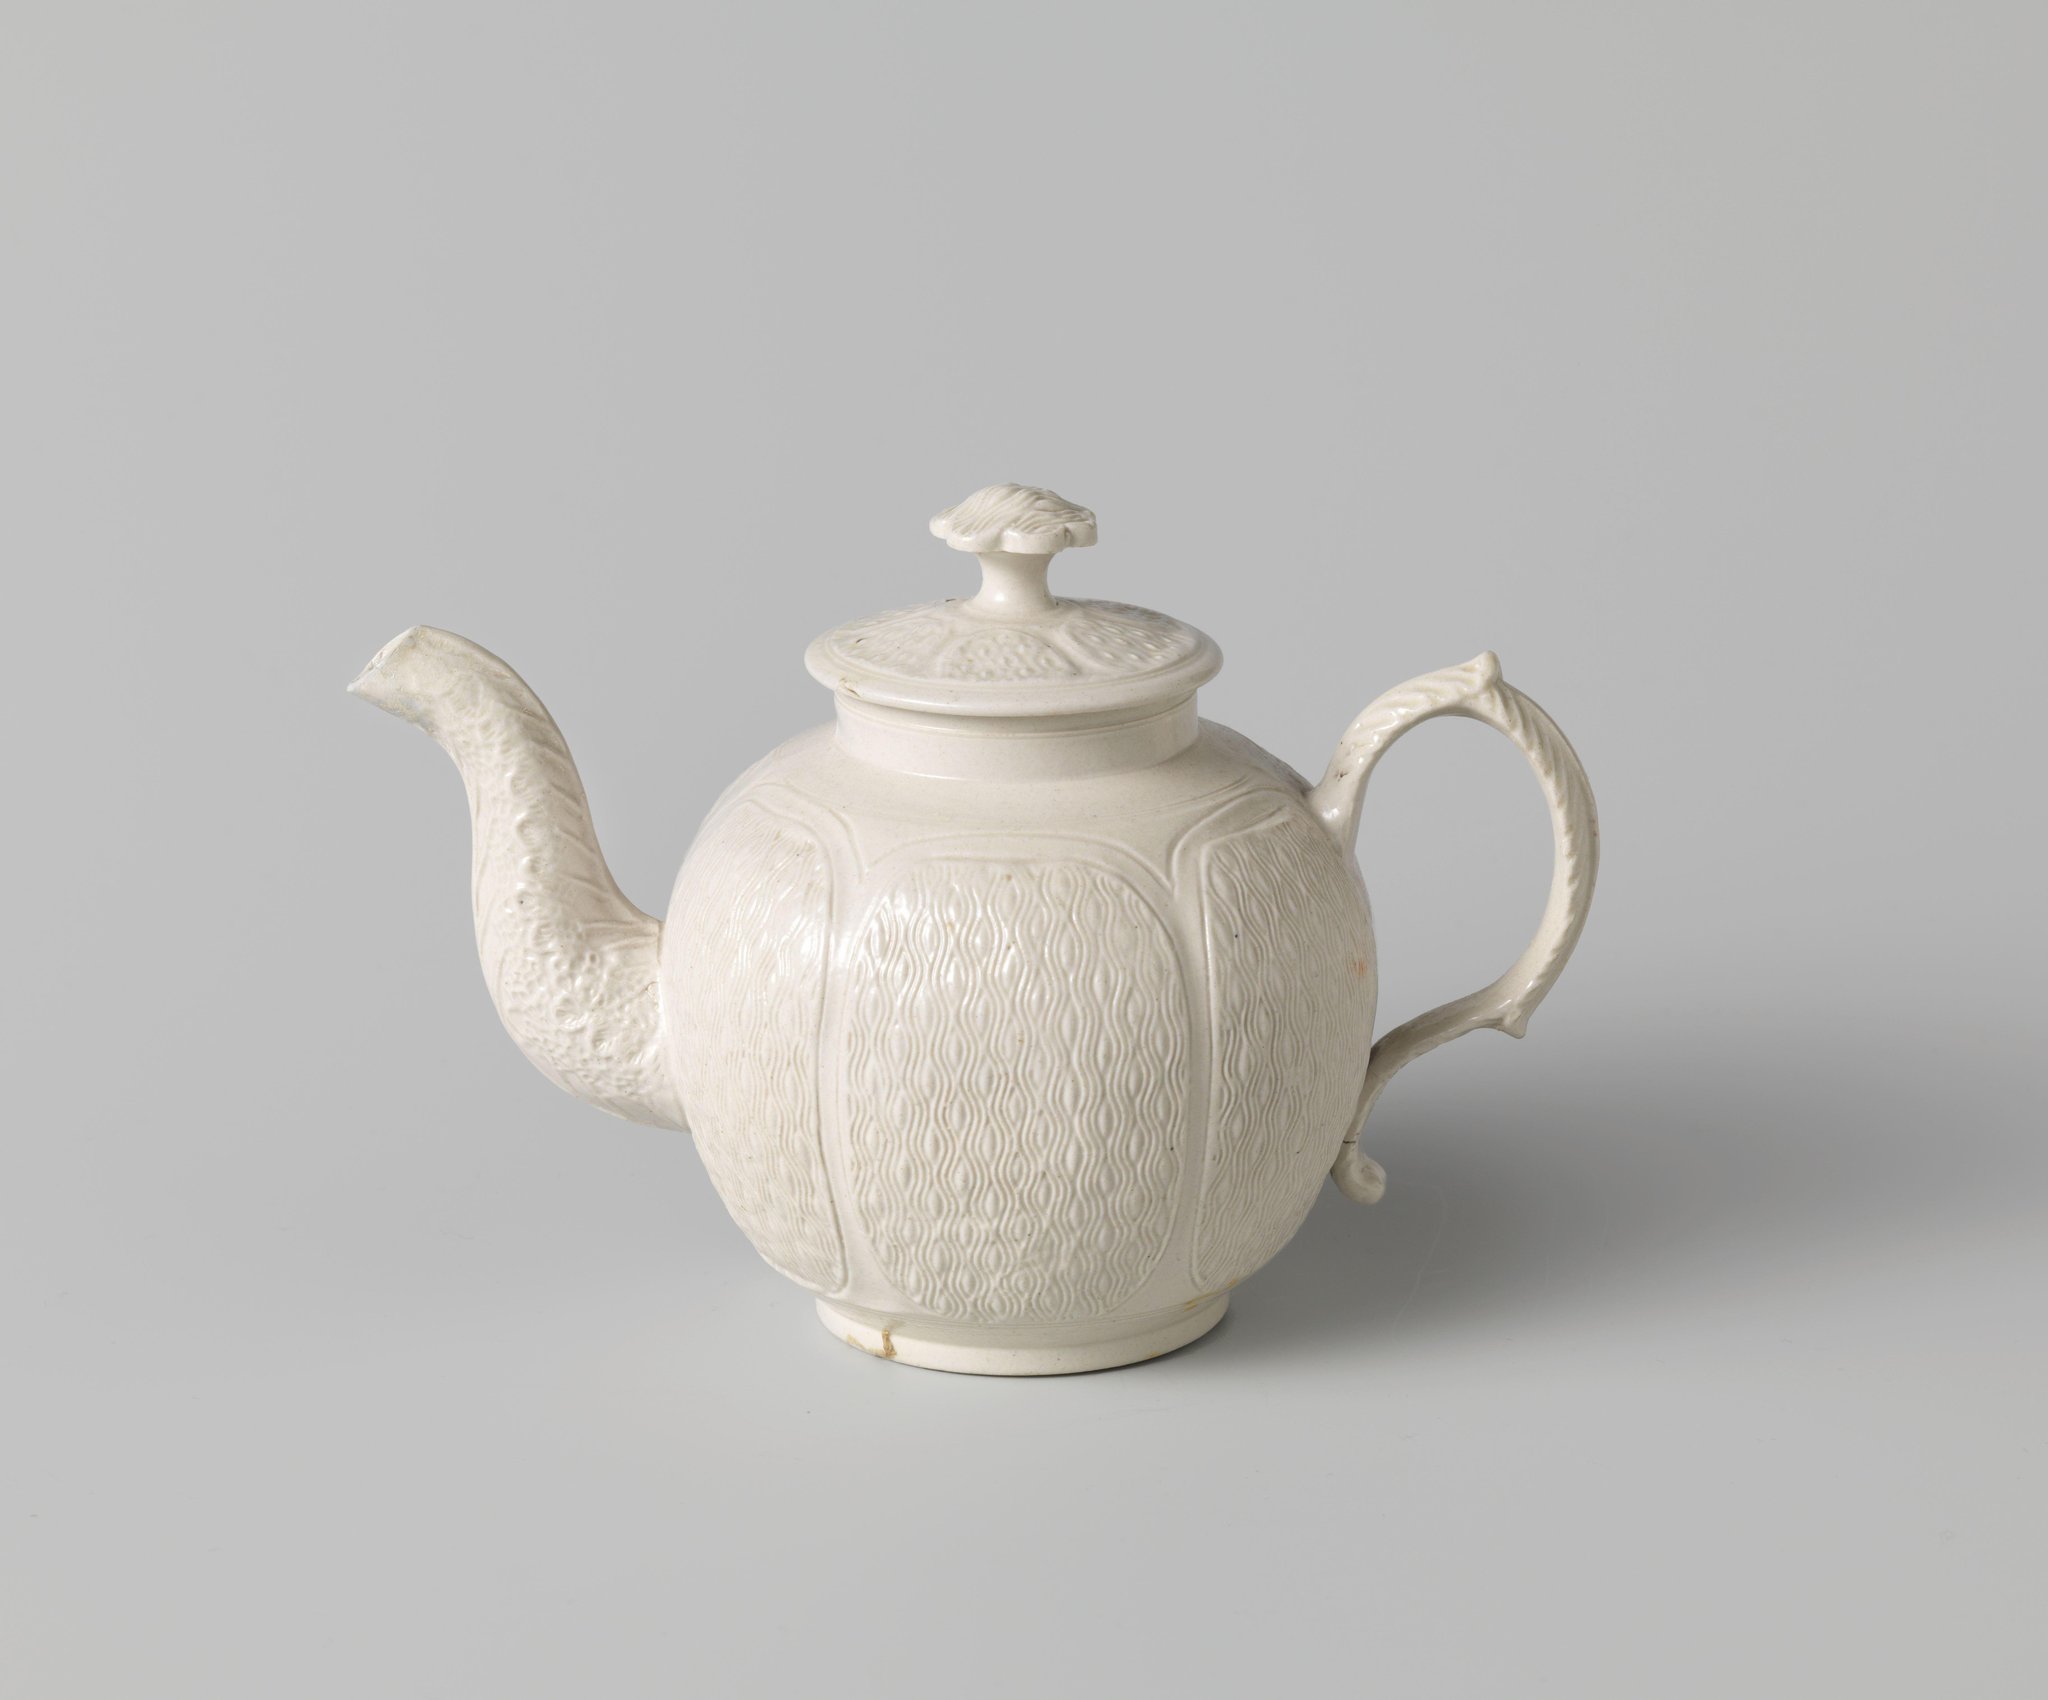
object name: teapot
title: Theepot van wit steengoed met reliëf versieringen; Staffordshire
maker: Anonymous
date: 1750-1765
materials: stoneware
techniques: salt glaze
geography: england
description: Tea pot. Stoneware. England, Staffordshire, c. 1750 - 1765.